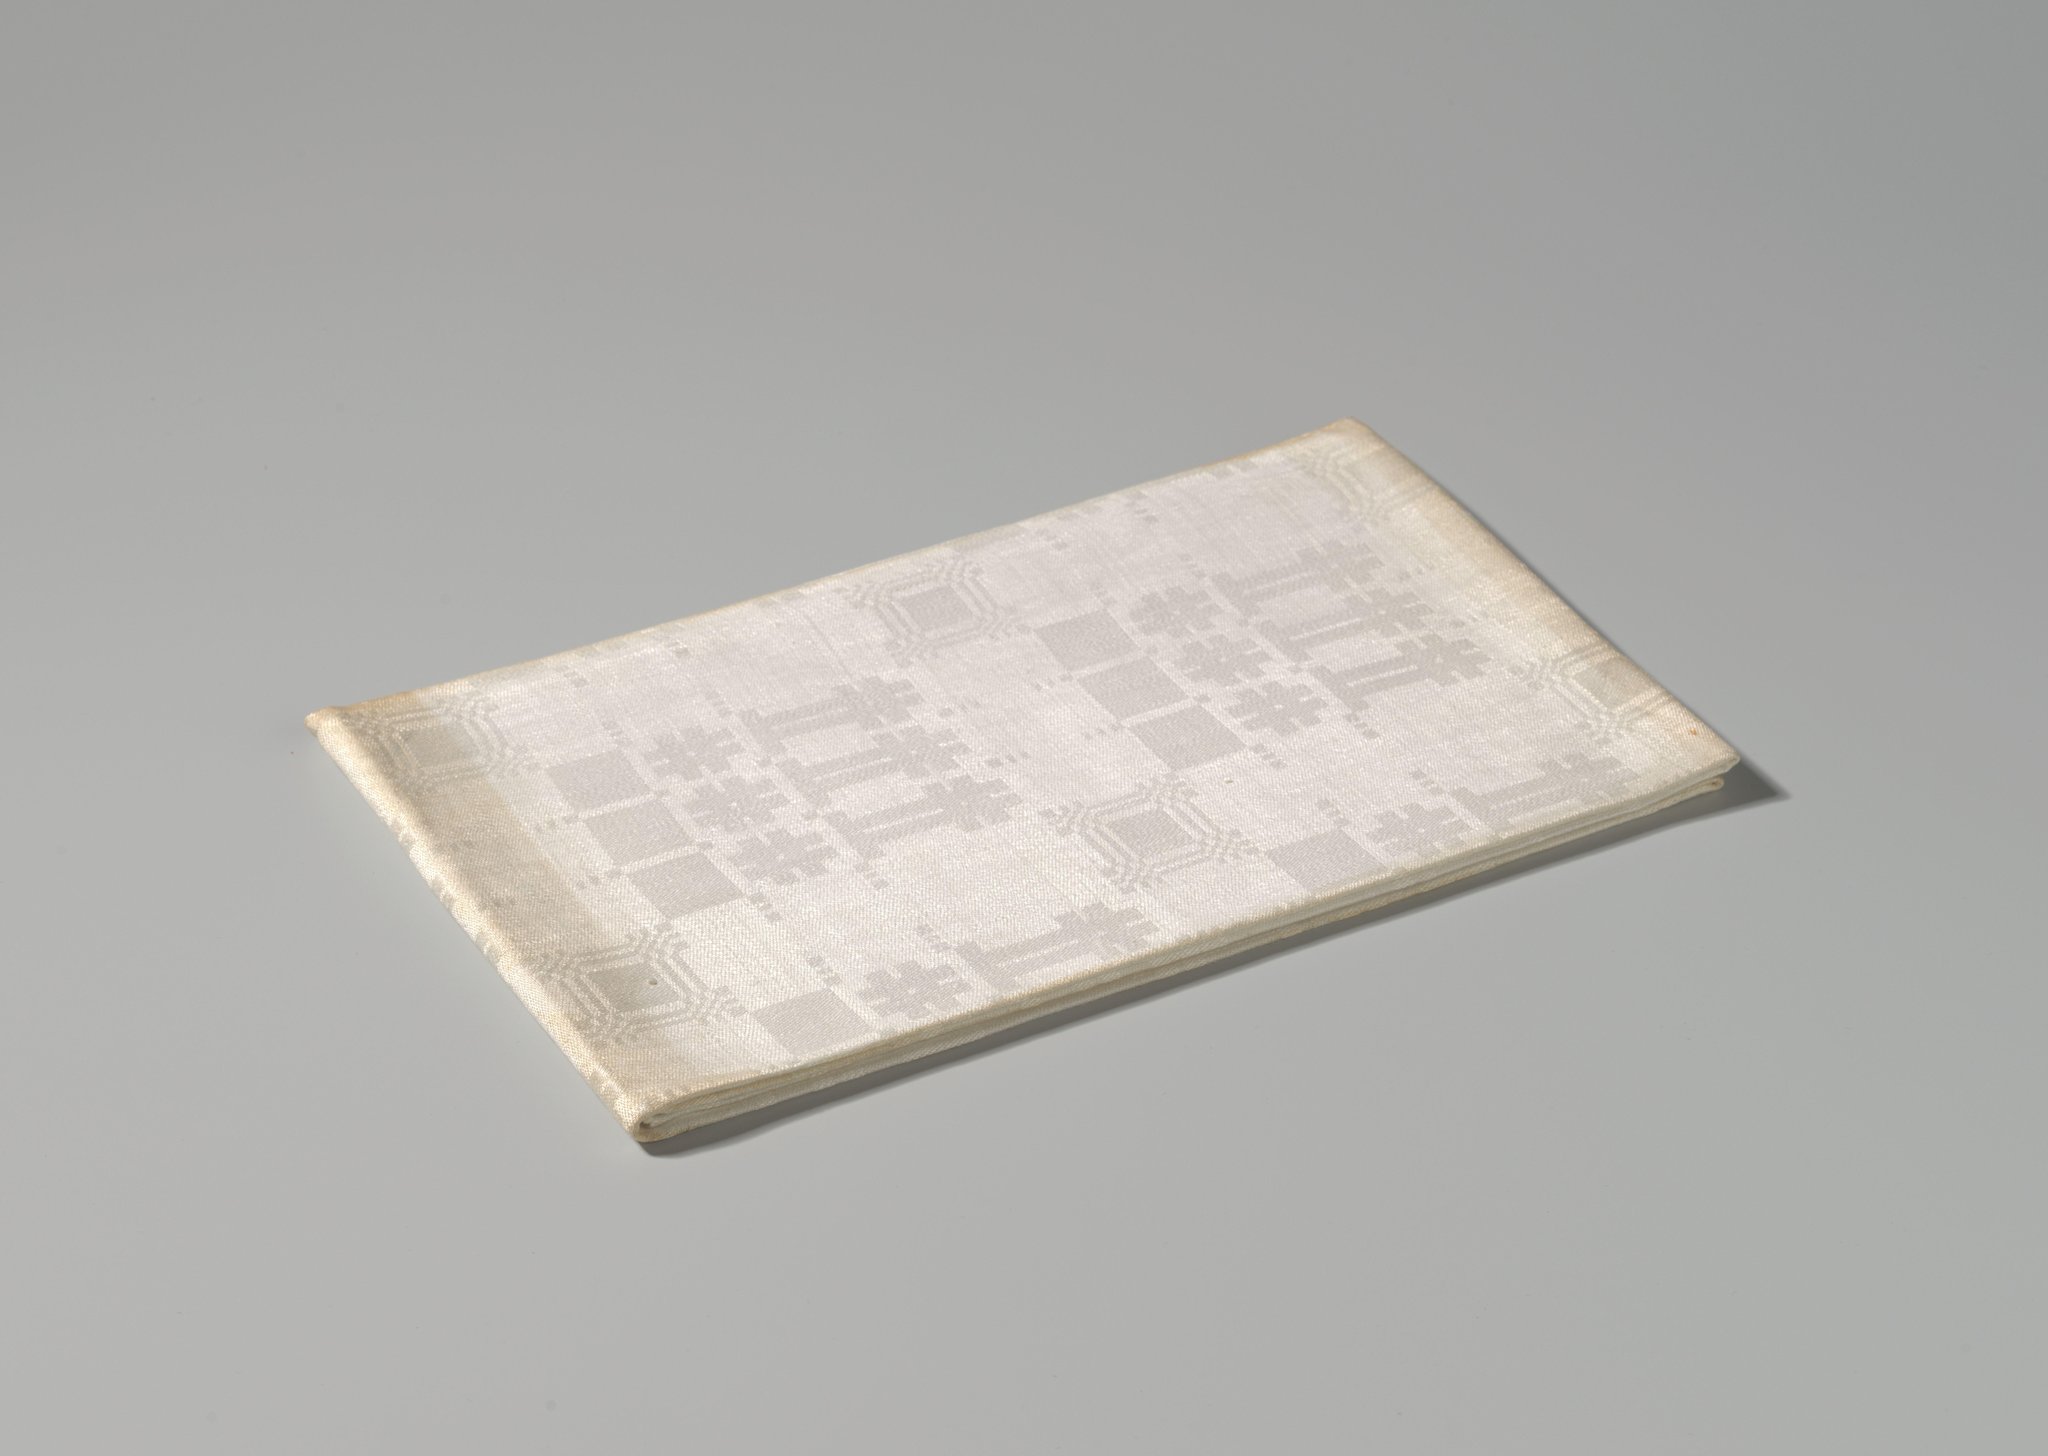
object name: handdwaal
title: Handdwaal van wit linnen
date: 1692-1735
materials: linen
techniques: damask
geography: northern netherlands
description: Wit linnen handdwaal met pellen patroon, merk kroon GS en (?).